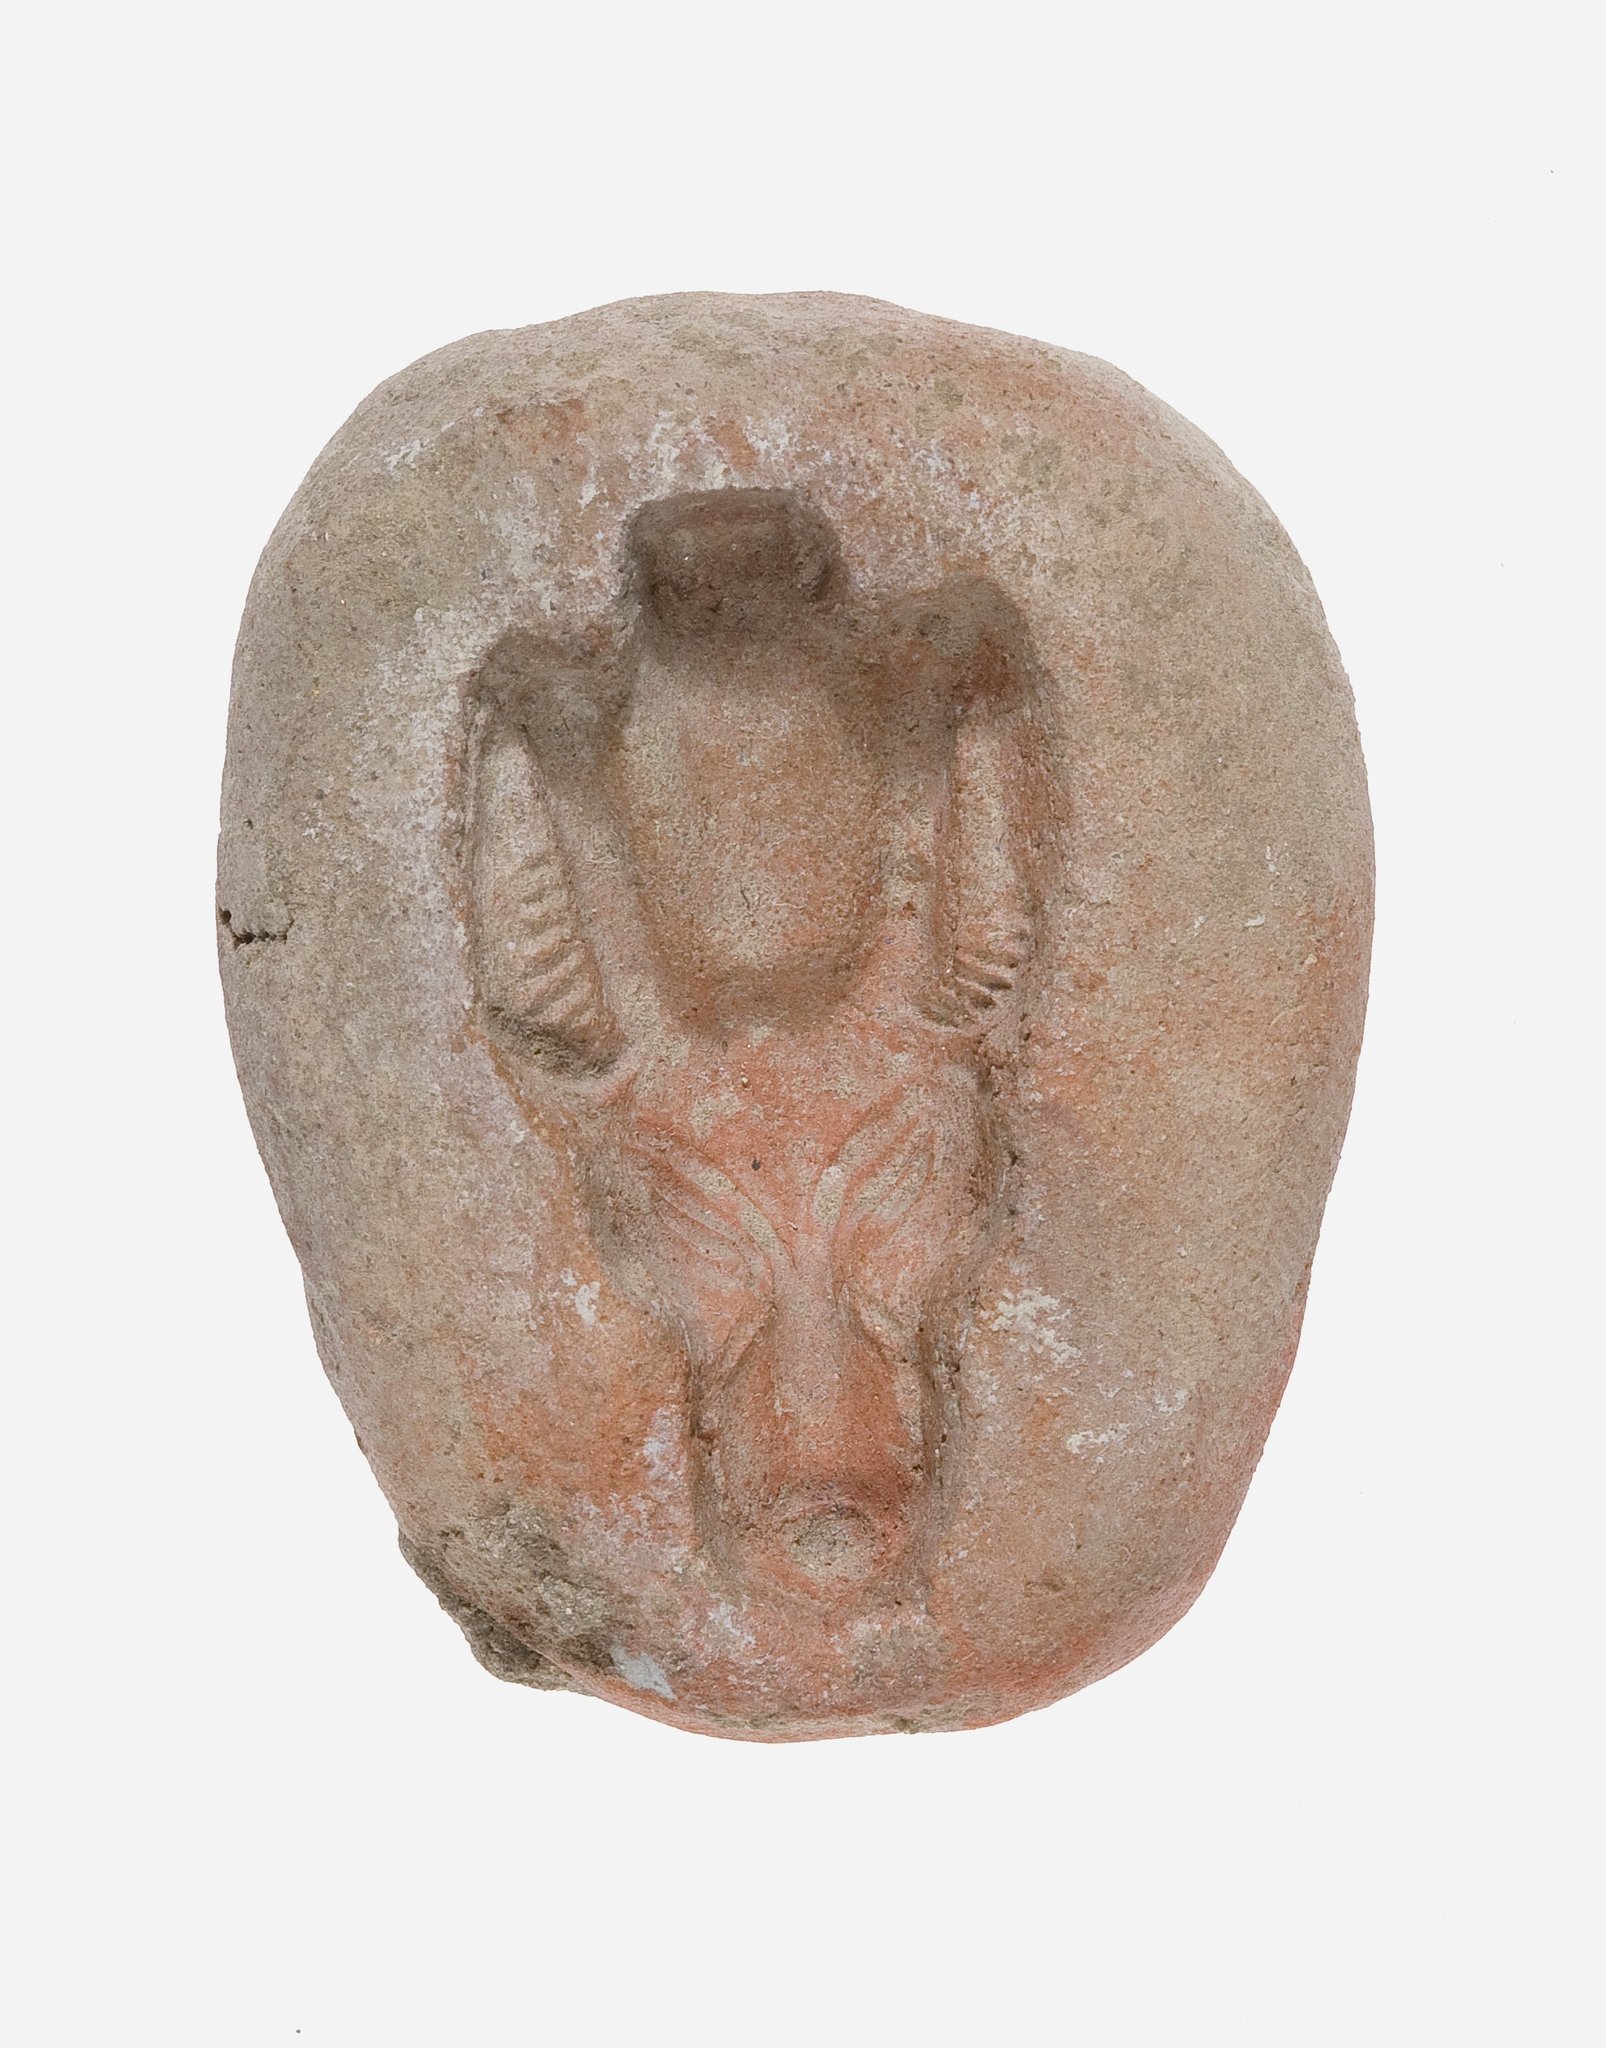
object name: mold, amulet, fox head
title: Mold for a Fox Head Amulet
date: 1390-1352 BCE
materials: pottery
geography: egypt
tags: foxes